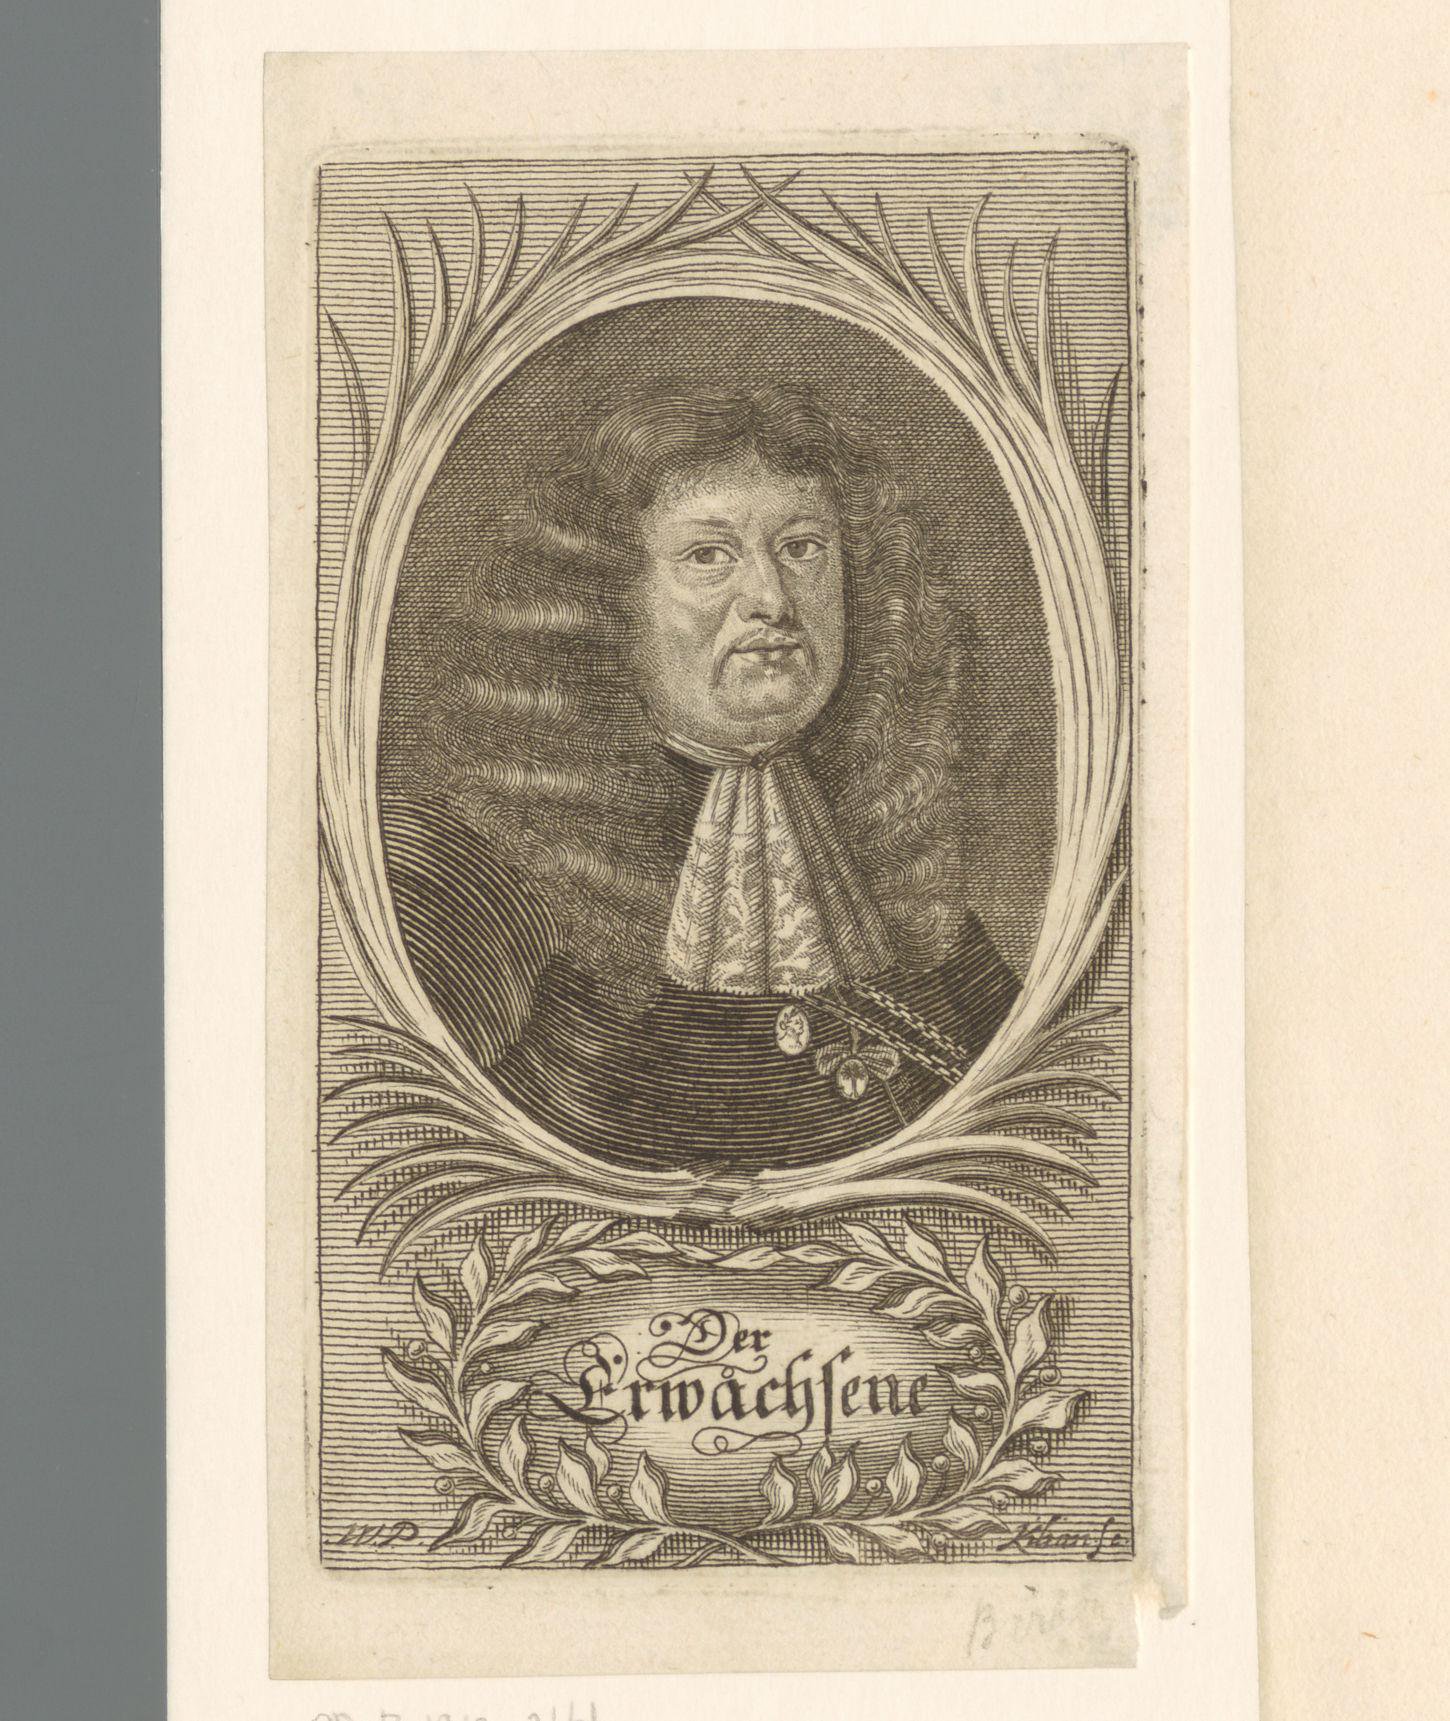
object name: print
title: Portret van Sigismund von Birken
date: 1669-1679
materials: paper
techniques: engraving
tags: sigismund von birken, historical persons, writer, poet, author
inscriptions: collector's mark: Lugt 2228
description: Onder het portret de naam van een gezelschap waar Sigismund von Birken toe behoorde: 'Der Erwachsene'.